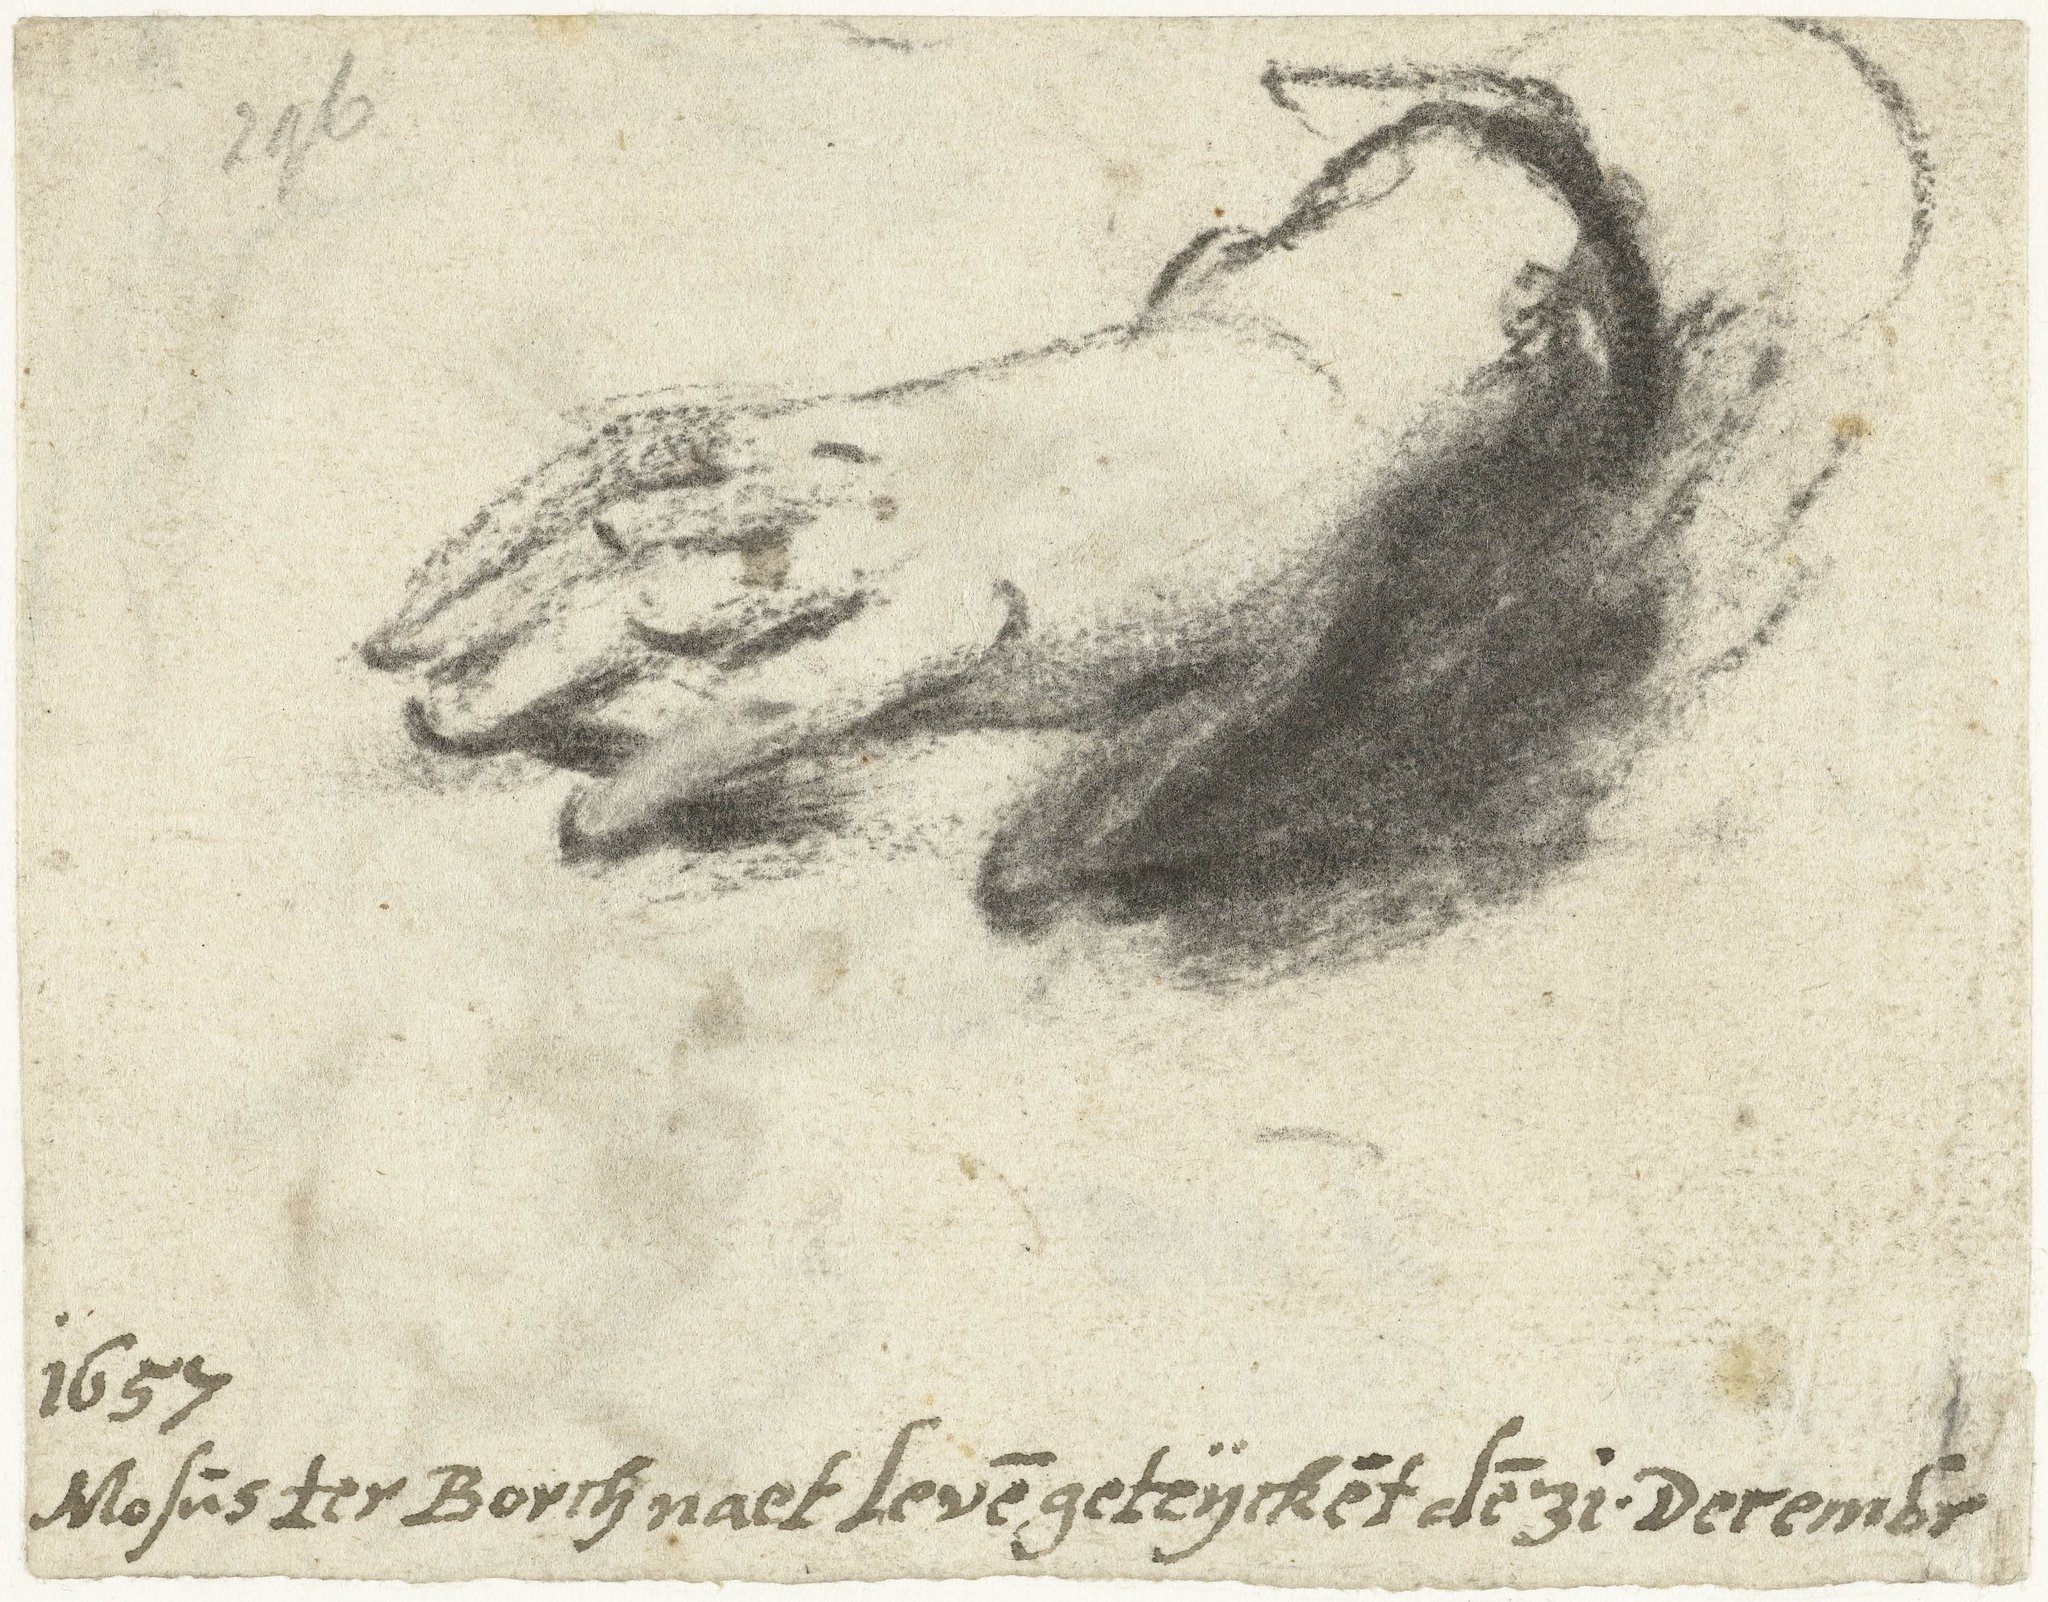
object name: drawing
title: Studie van een hand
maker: moses ter borch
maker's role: draughtsman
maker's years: 1645-1667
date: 1657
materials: chalk, paper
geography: zwolle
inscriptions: annotation: ‘1657 / Mosus ter Borch naet leven geteijckent den 31.Decembr’